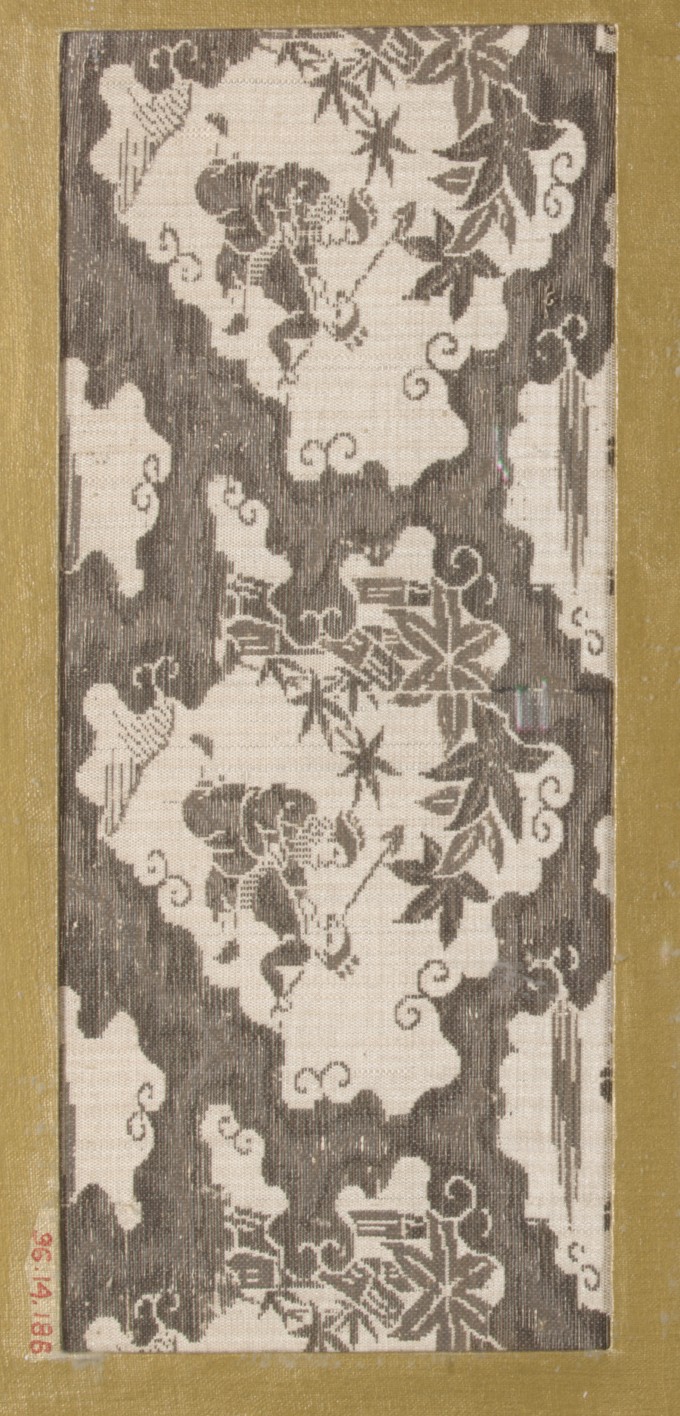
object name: fragment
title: Textile fragment with repeating pattern of irregularly shaped cloud-edged vignettes containing two human figures and maple leaves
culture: japanese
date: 1701-1900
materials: silk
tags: human figures